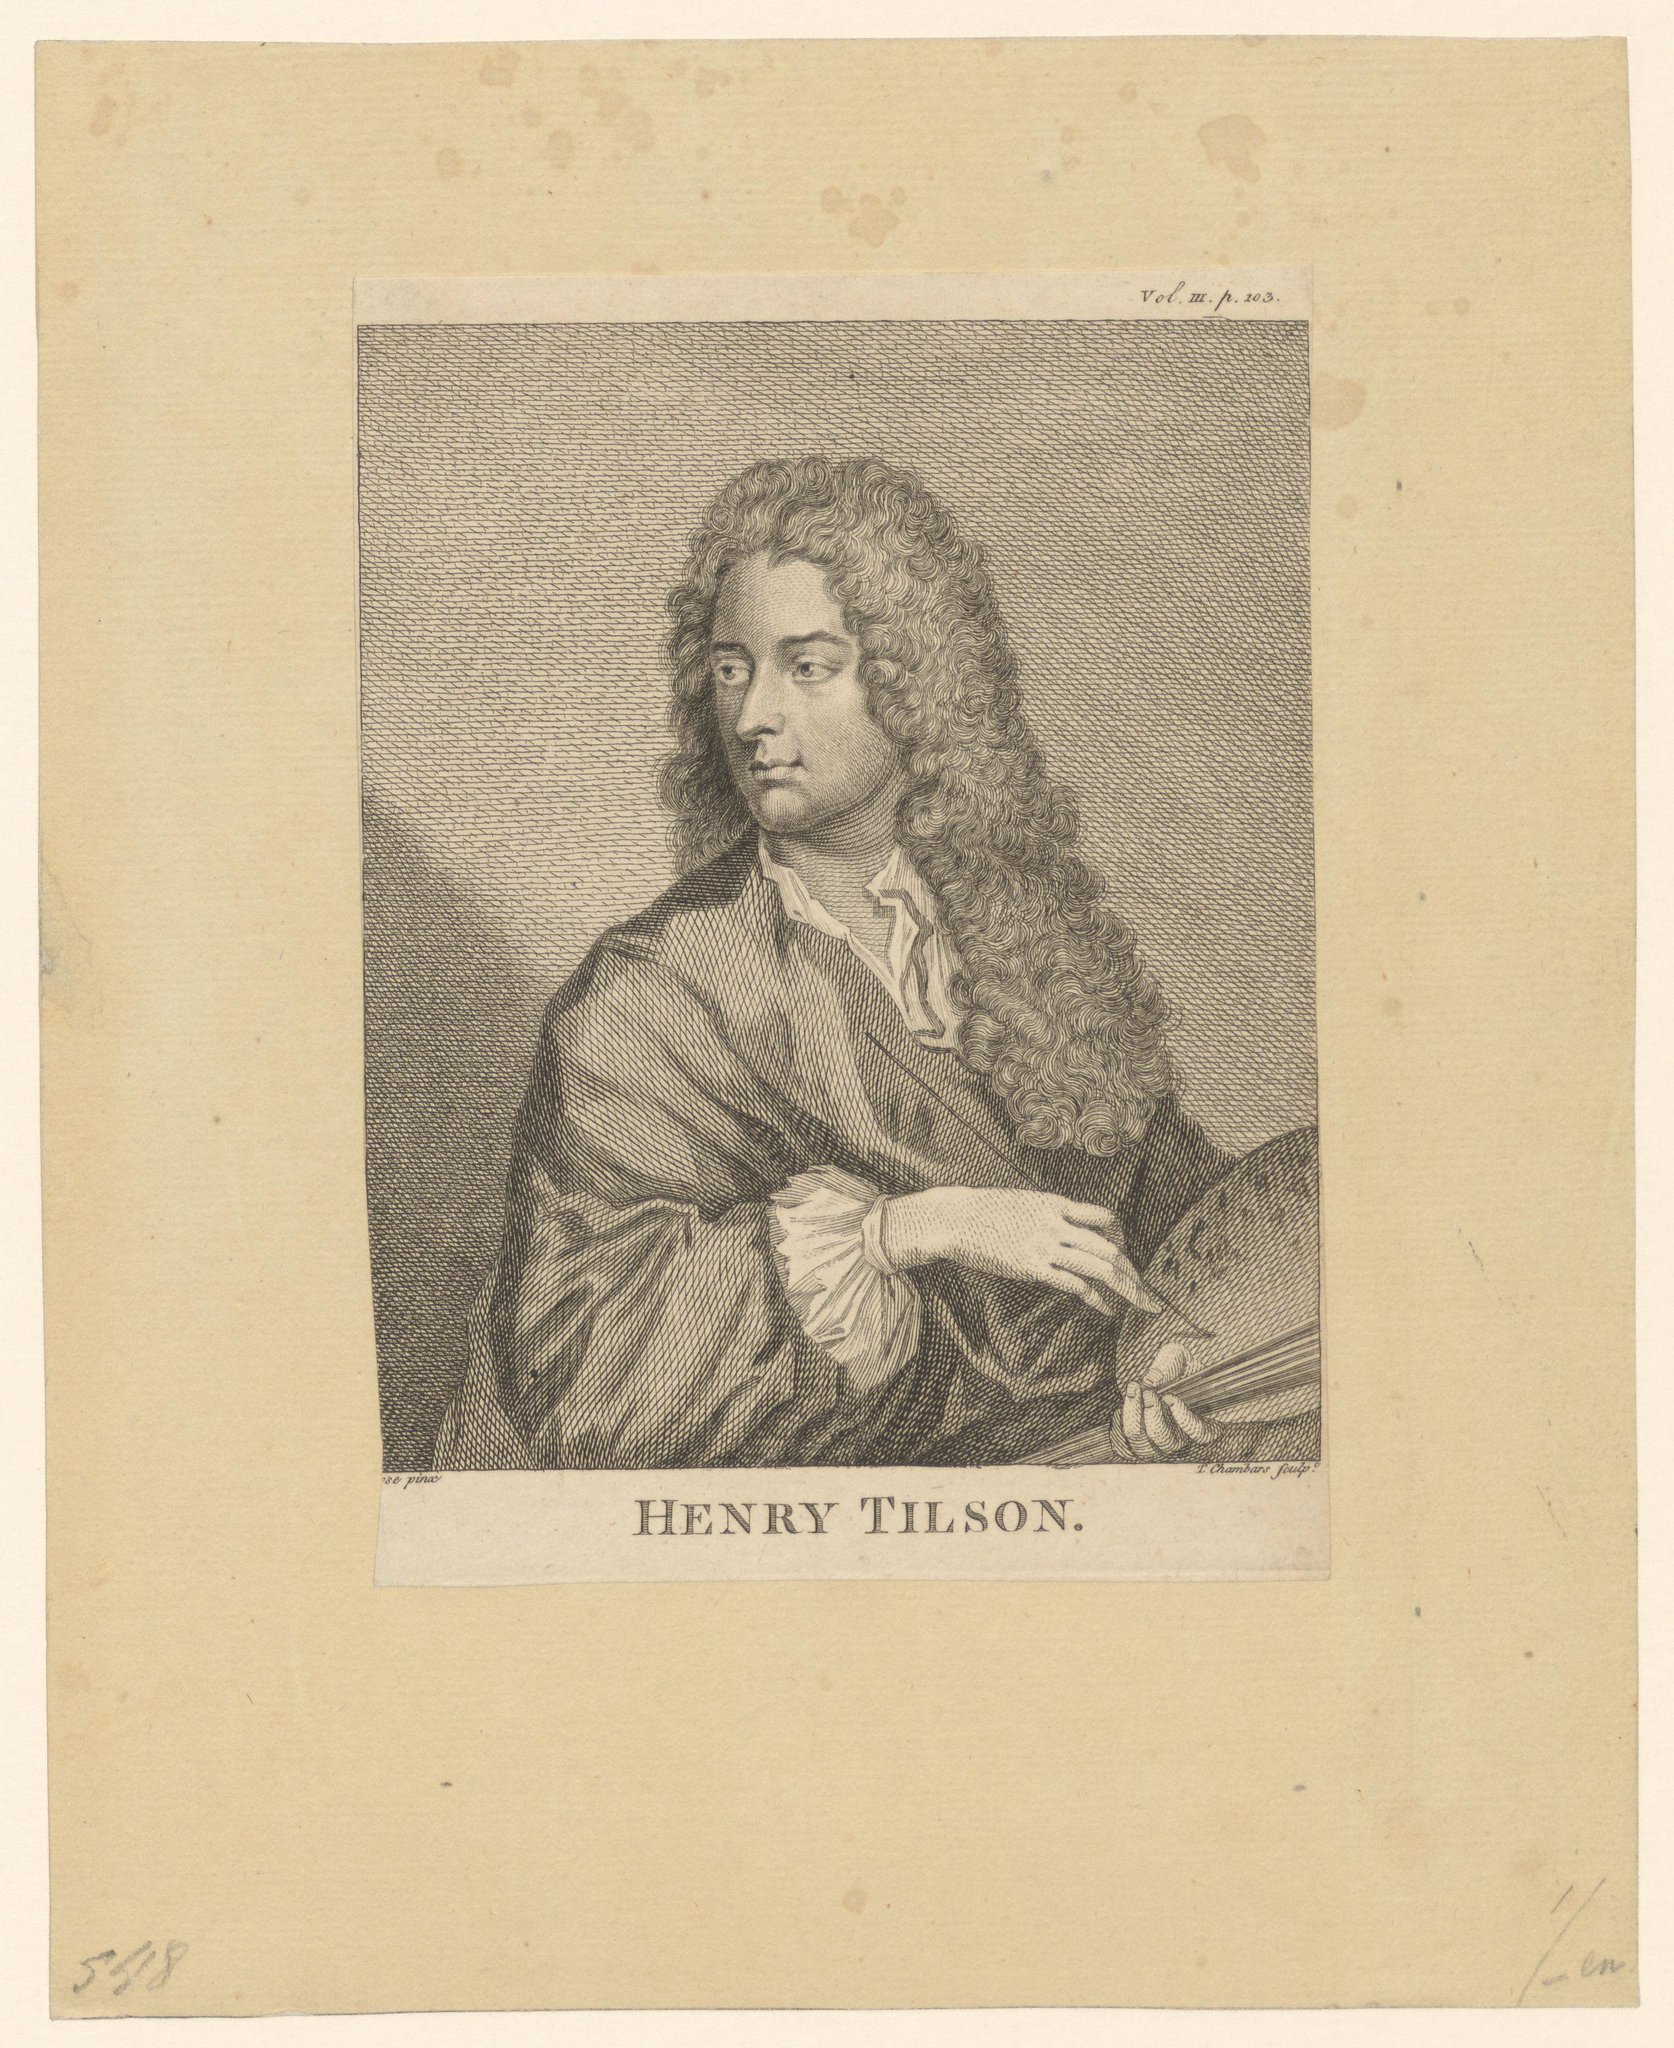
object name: book illustration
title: Portret van Henry Tilson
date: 1734-1762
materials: paper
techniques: engraving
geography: london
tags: henry tilson, historical persons, portrait, self-portrait of painter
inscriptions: collector's mark: Lugt 2228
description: Prent uit: Walpole, Horace. Anecdotes of painting in England : with some account of the principal artists : and incidental notes on other arts; collected by the late Mr. George Vertue : and now digested and published from his original Mss. / by Horace Walpole. 4 dln. Londen: Horace Walpole, [1762-1789], dl. 3, p. 103.